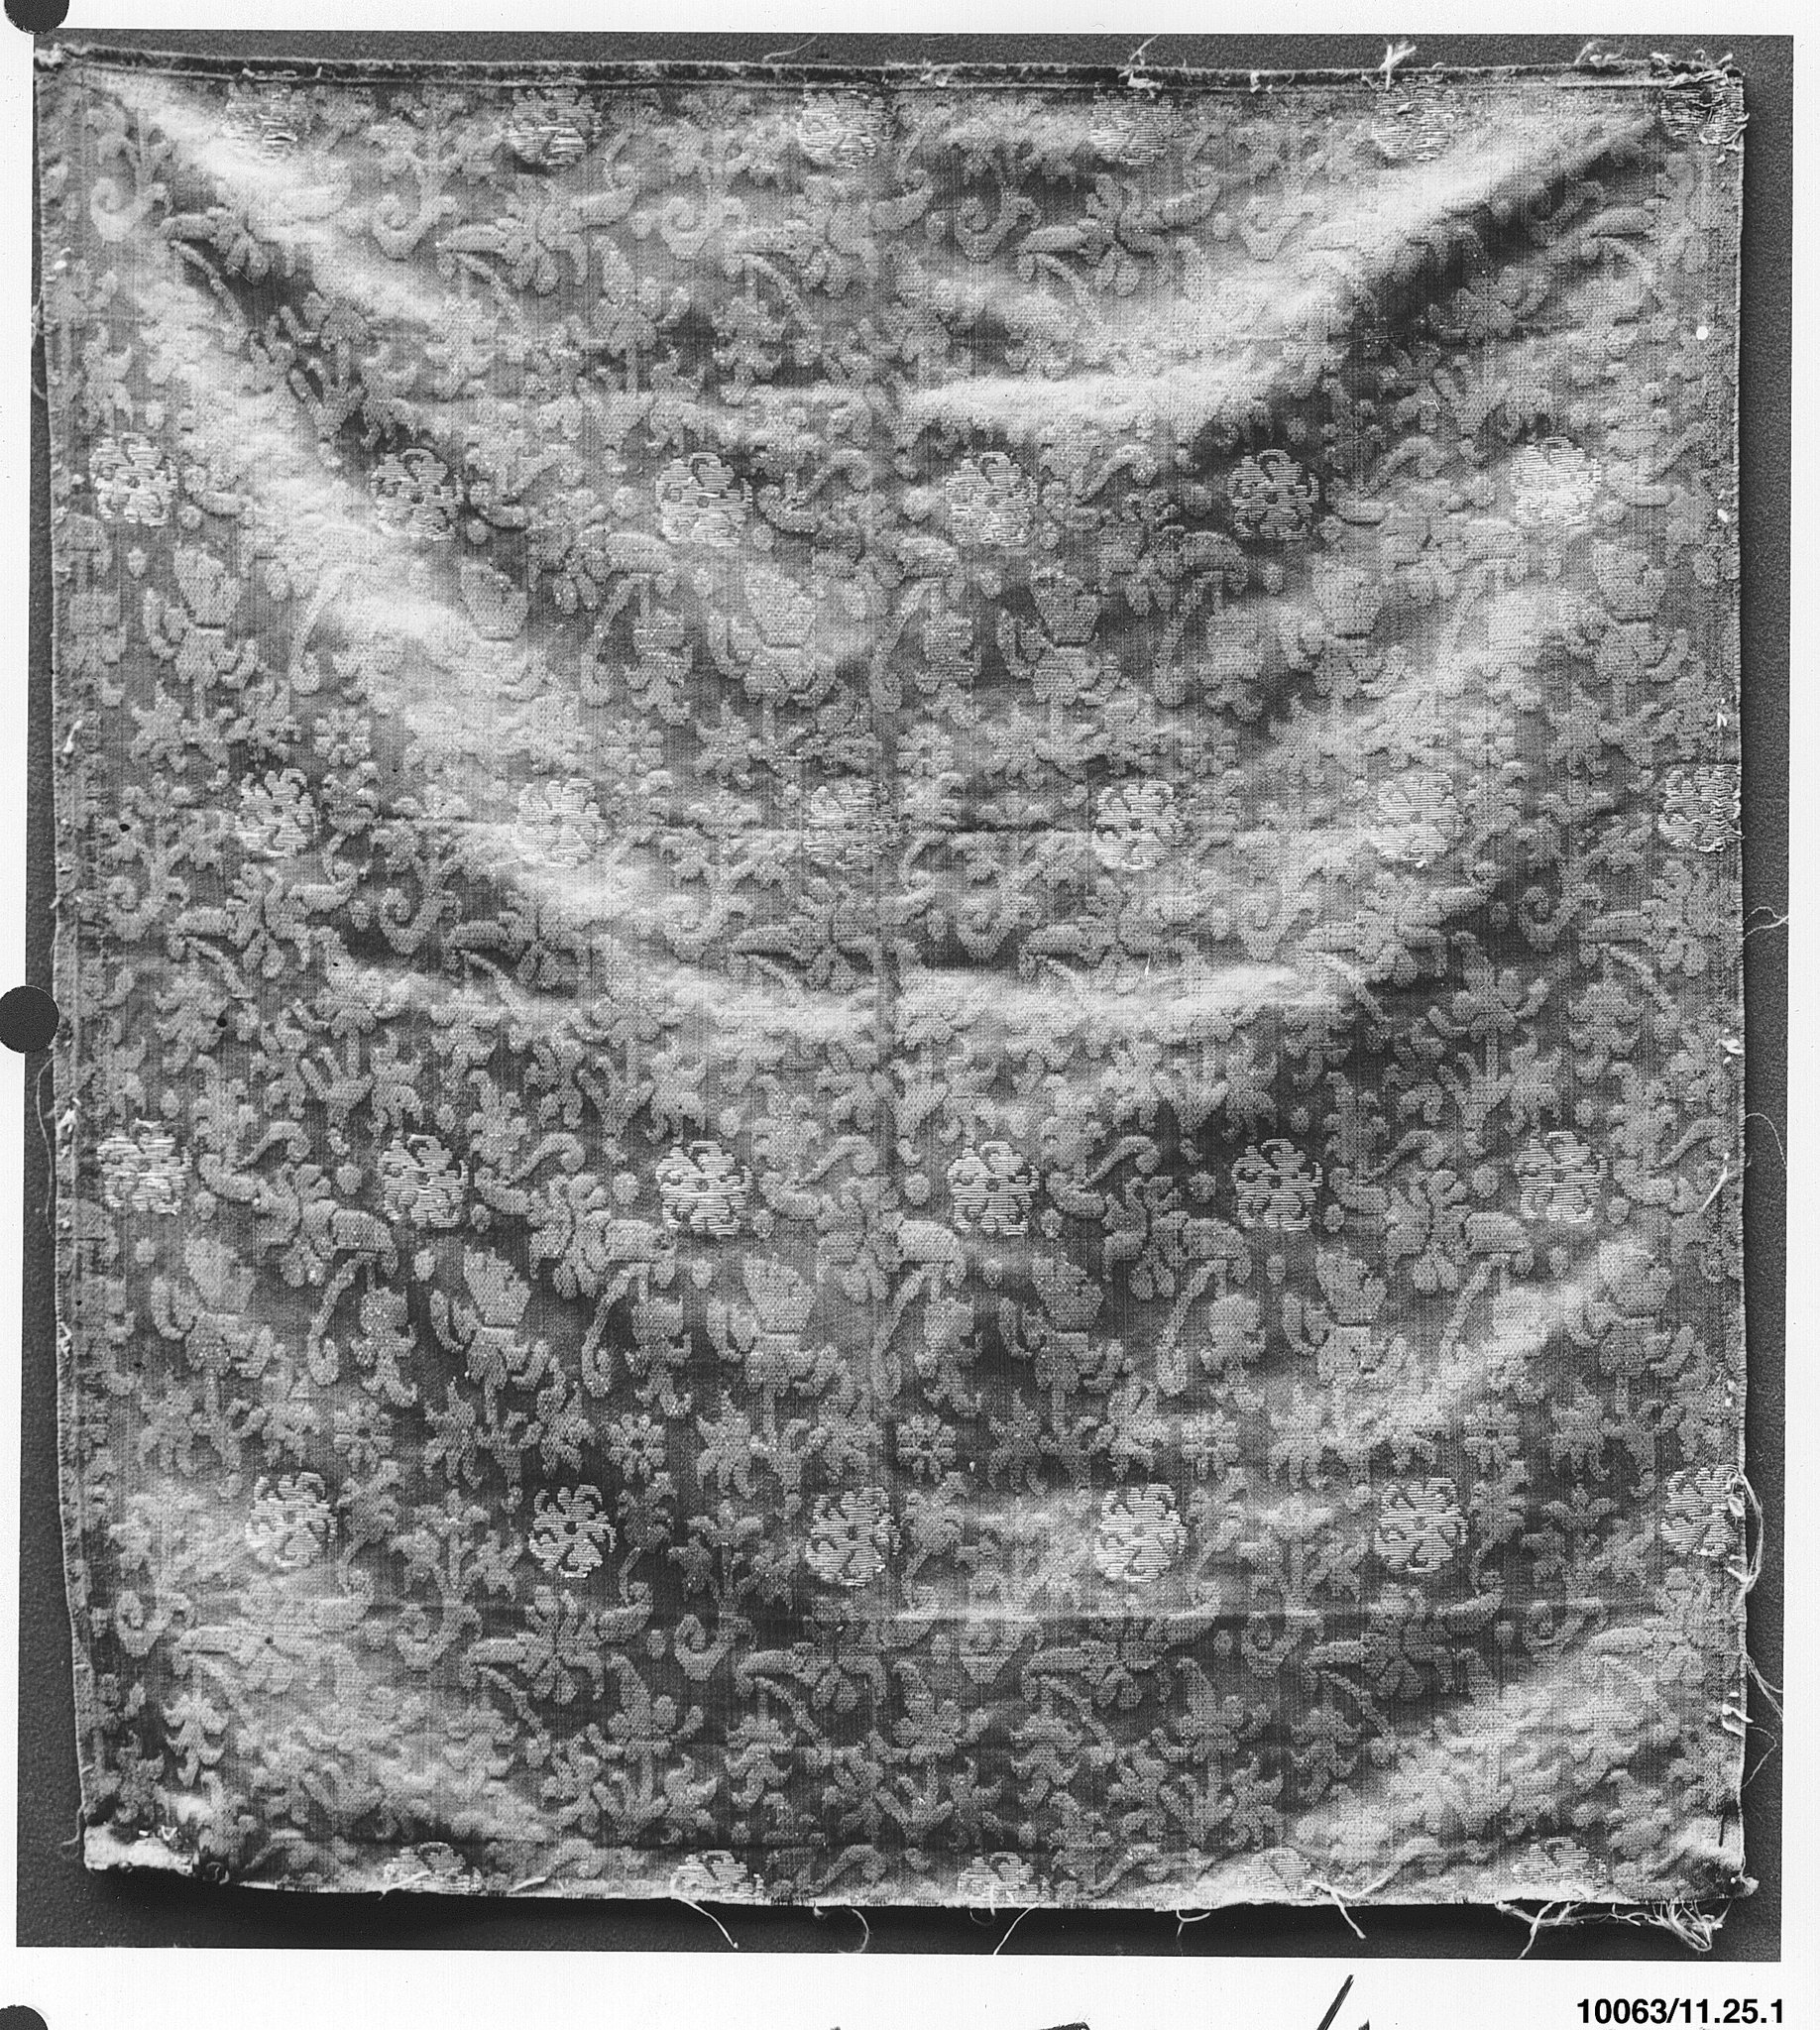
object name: piece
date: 1501-1600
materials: metal thread, silk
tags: flowers,leaves